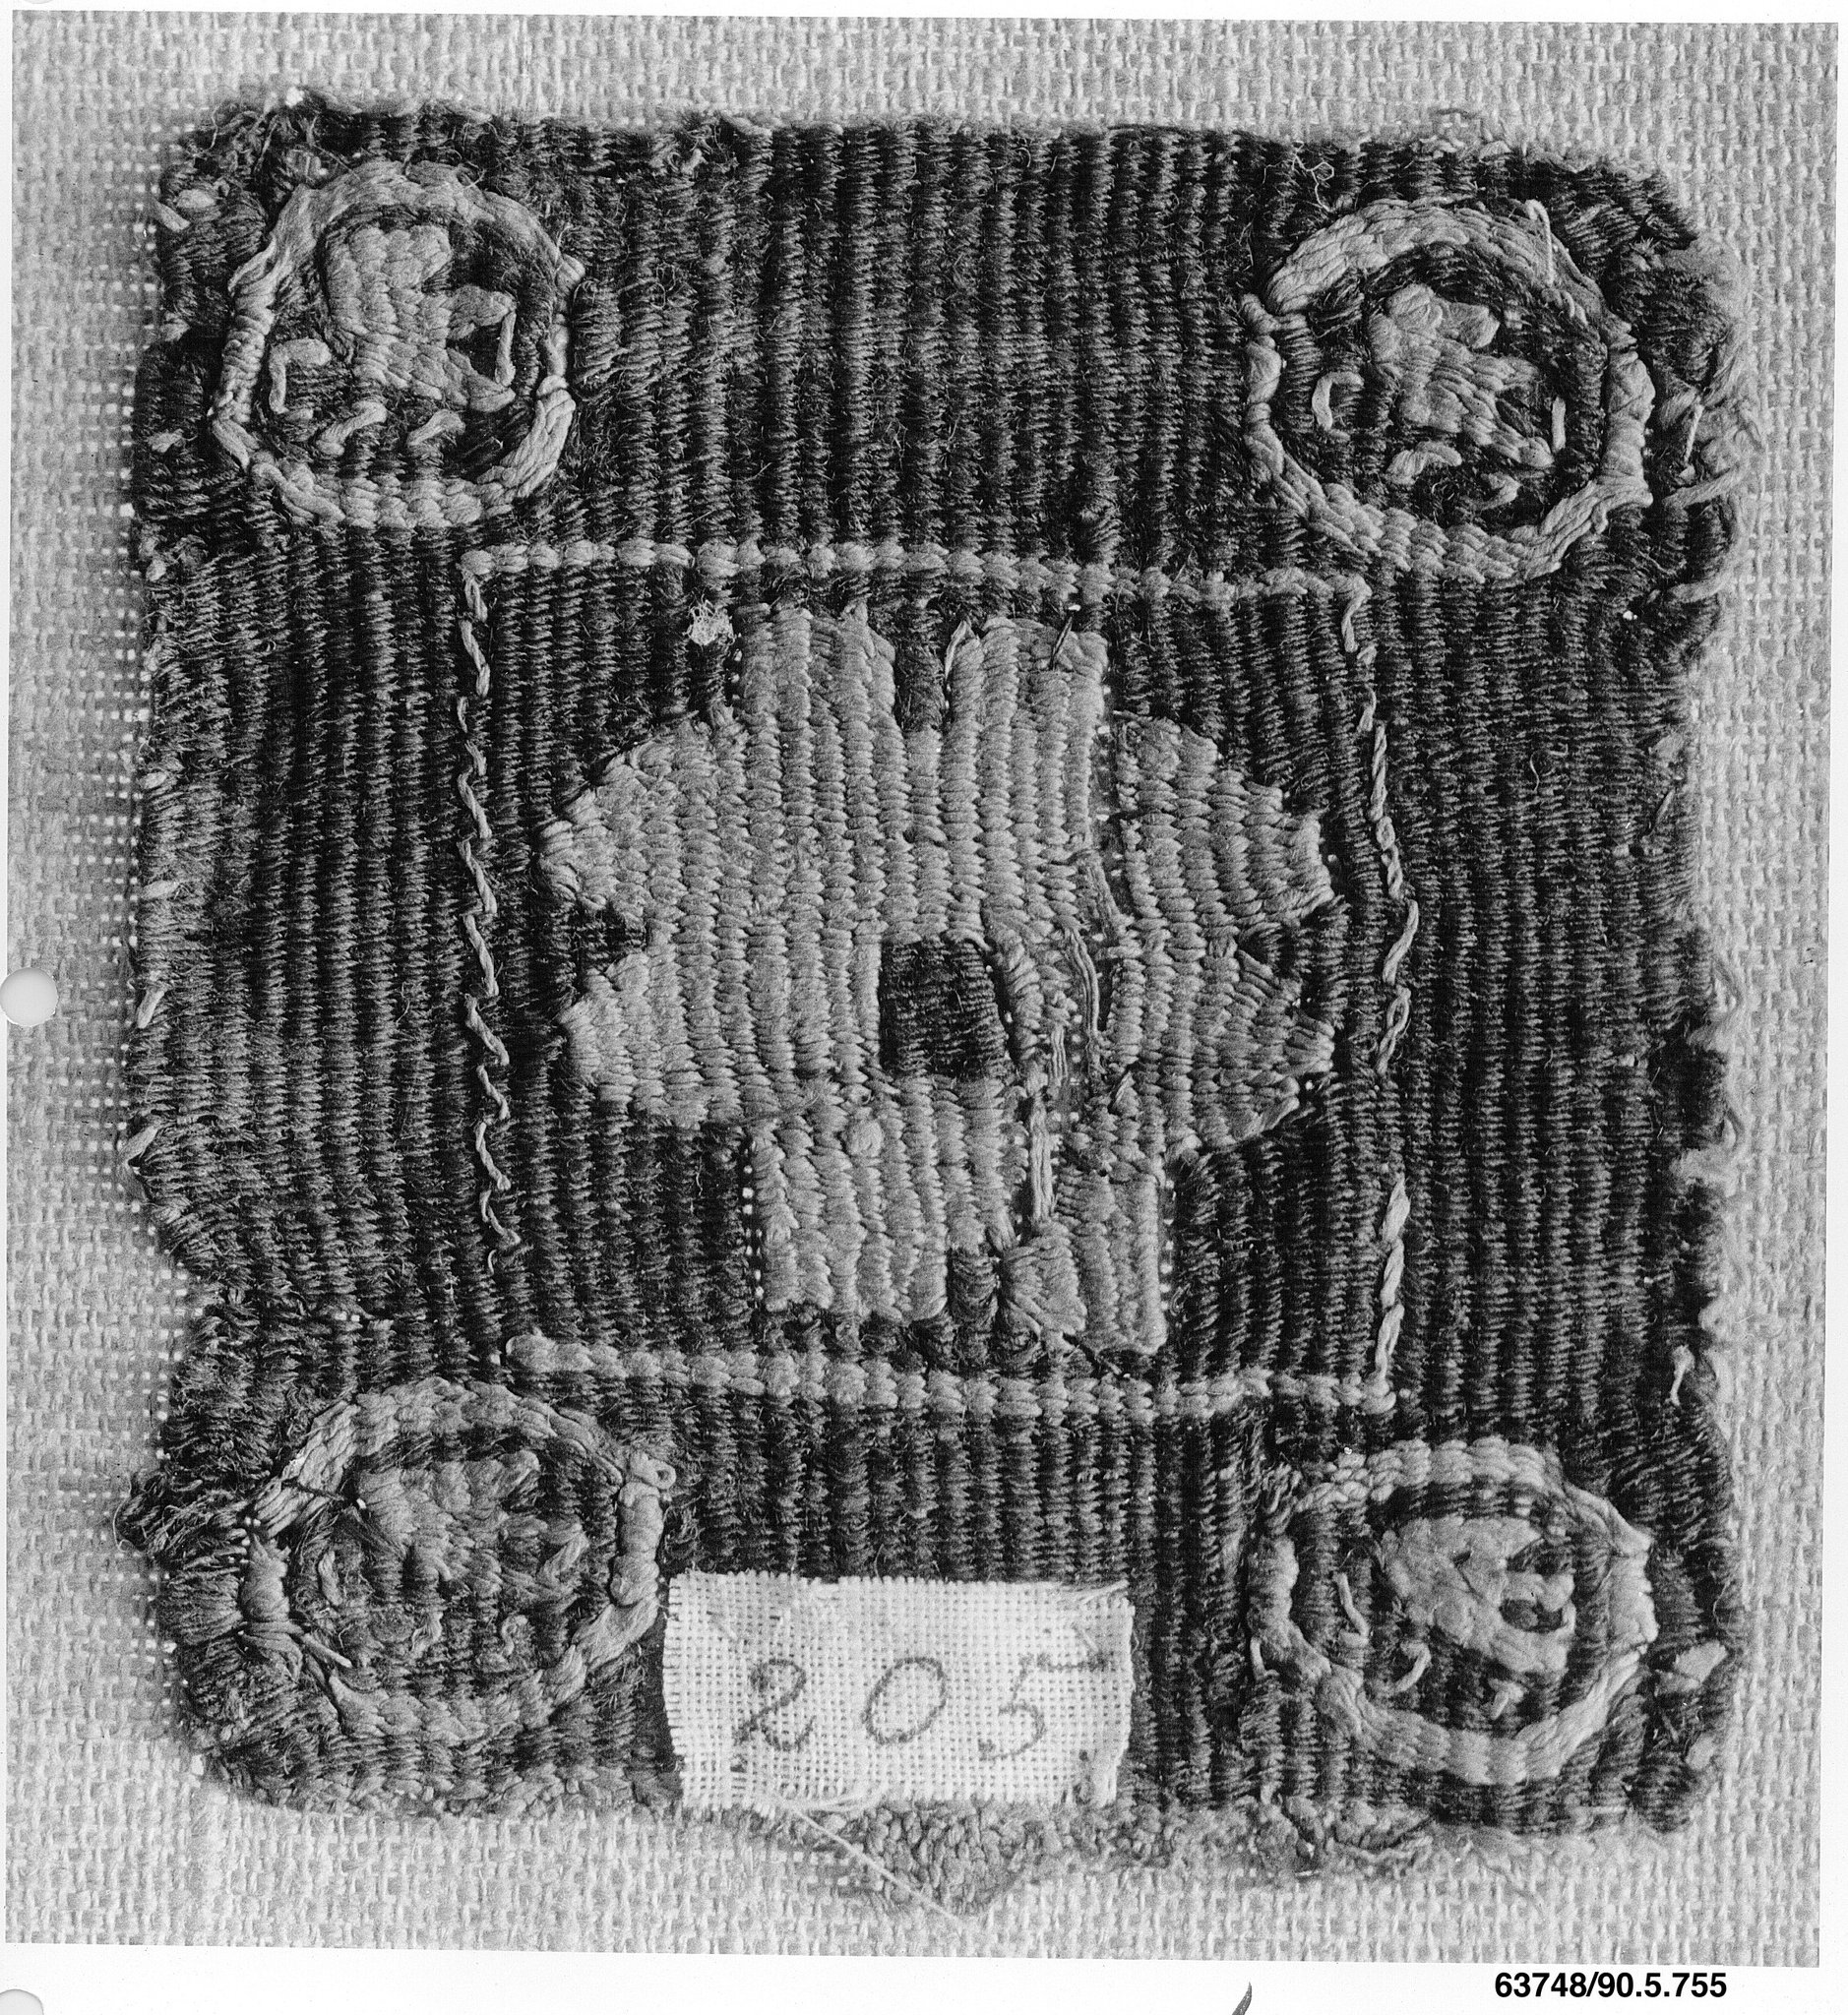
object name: textile fragment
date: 301-500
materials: linen, wool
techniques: weave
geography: egypt